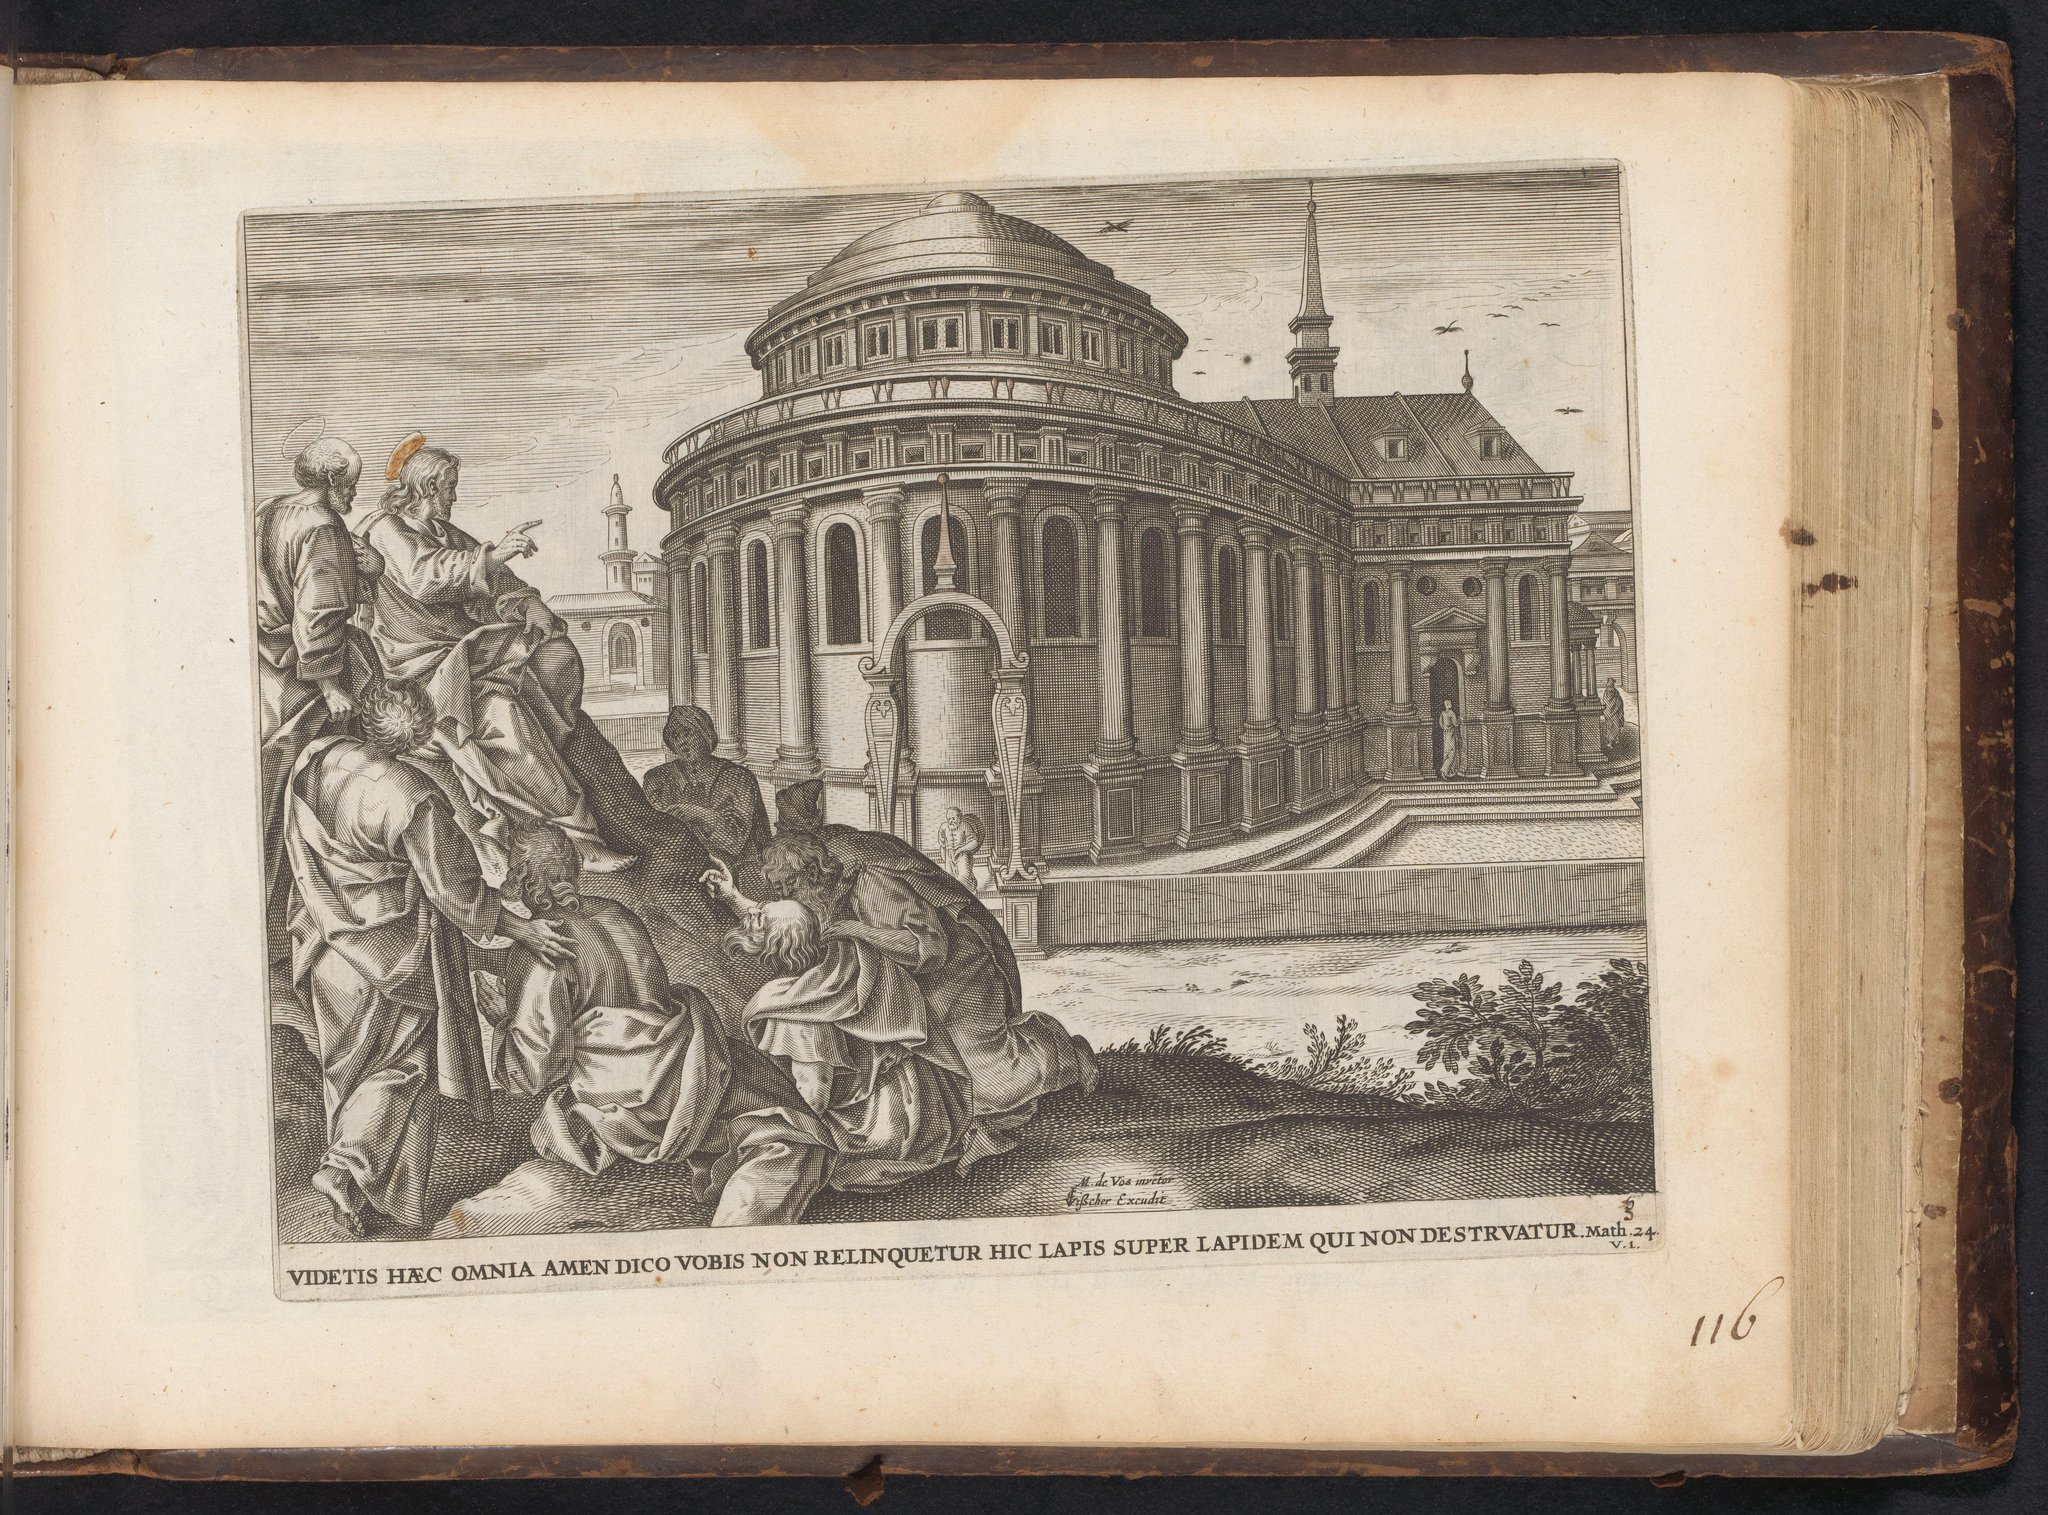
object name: album leaf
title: Vorder geschiedenissen binnen Ierusalem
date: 1646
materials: paper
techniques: engraving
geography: alkmaar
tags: sayings of christ: discourse on the last things (matthew 24; mark 13; luke 21)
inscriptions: serial number: ‘3’, number: ‘116’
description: Links op de voorgrond zit Christus. Hij vertelt zijn leerlingen, terwijl hij wijst op de tempelgebouwen, dat geen steen op de andere zal blijven staan. Onder de voorstelling een verwijzing in het Latijn naar de Bijbeltekst in Mat. 24:1. Deze prent maakt deel uit van een album.